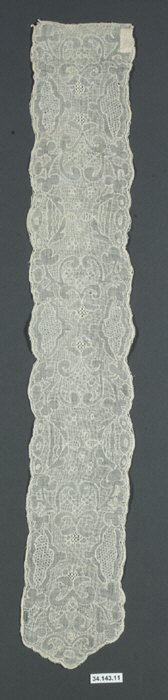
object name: lappet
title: Lappet (one of a pair)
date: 1701-1800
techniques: embroidery